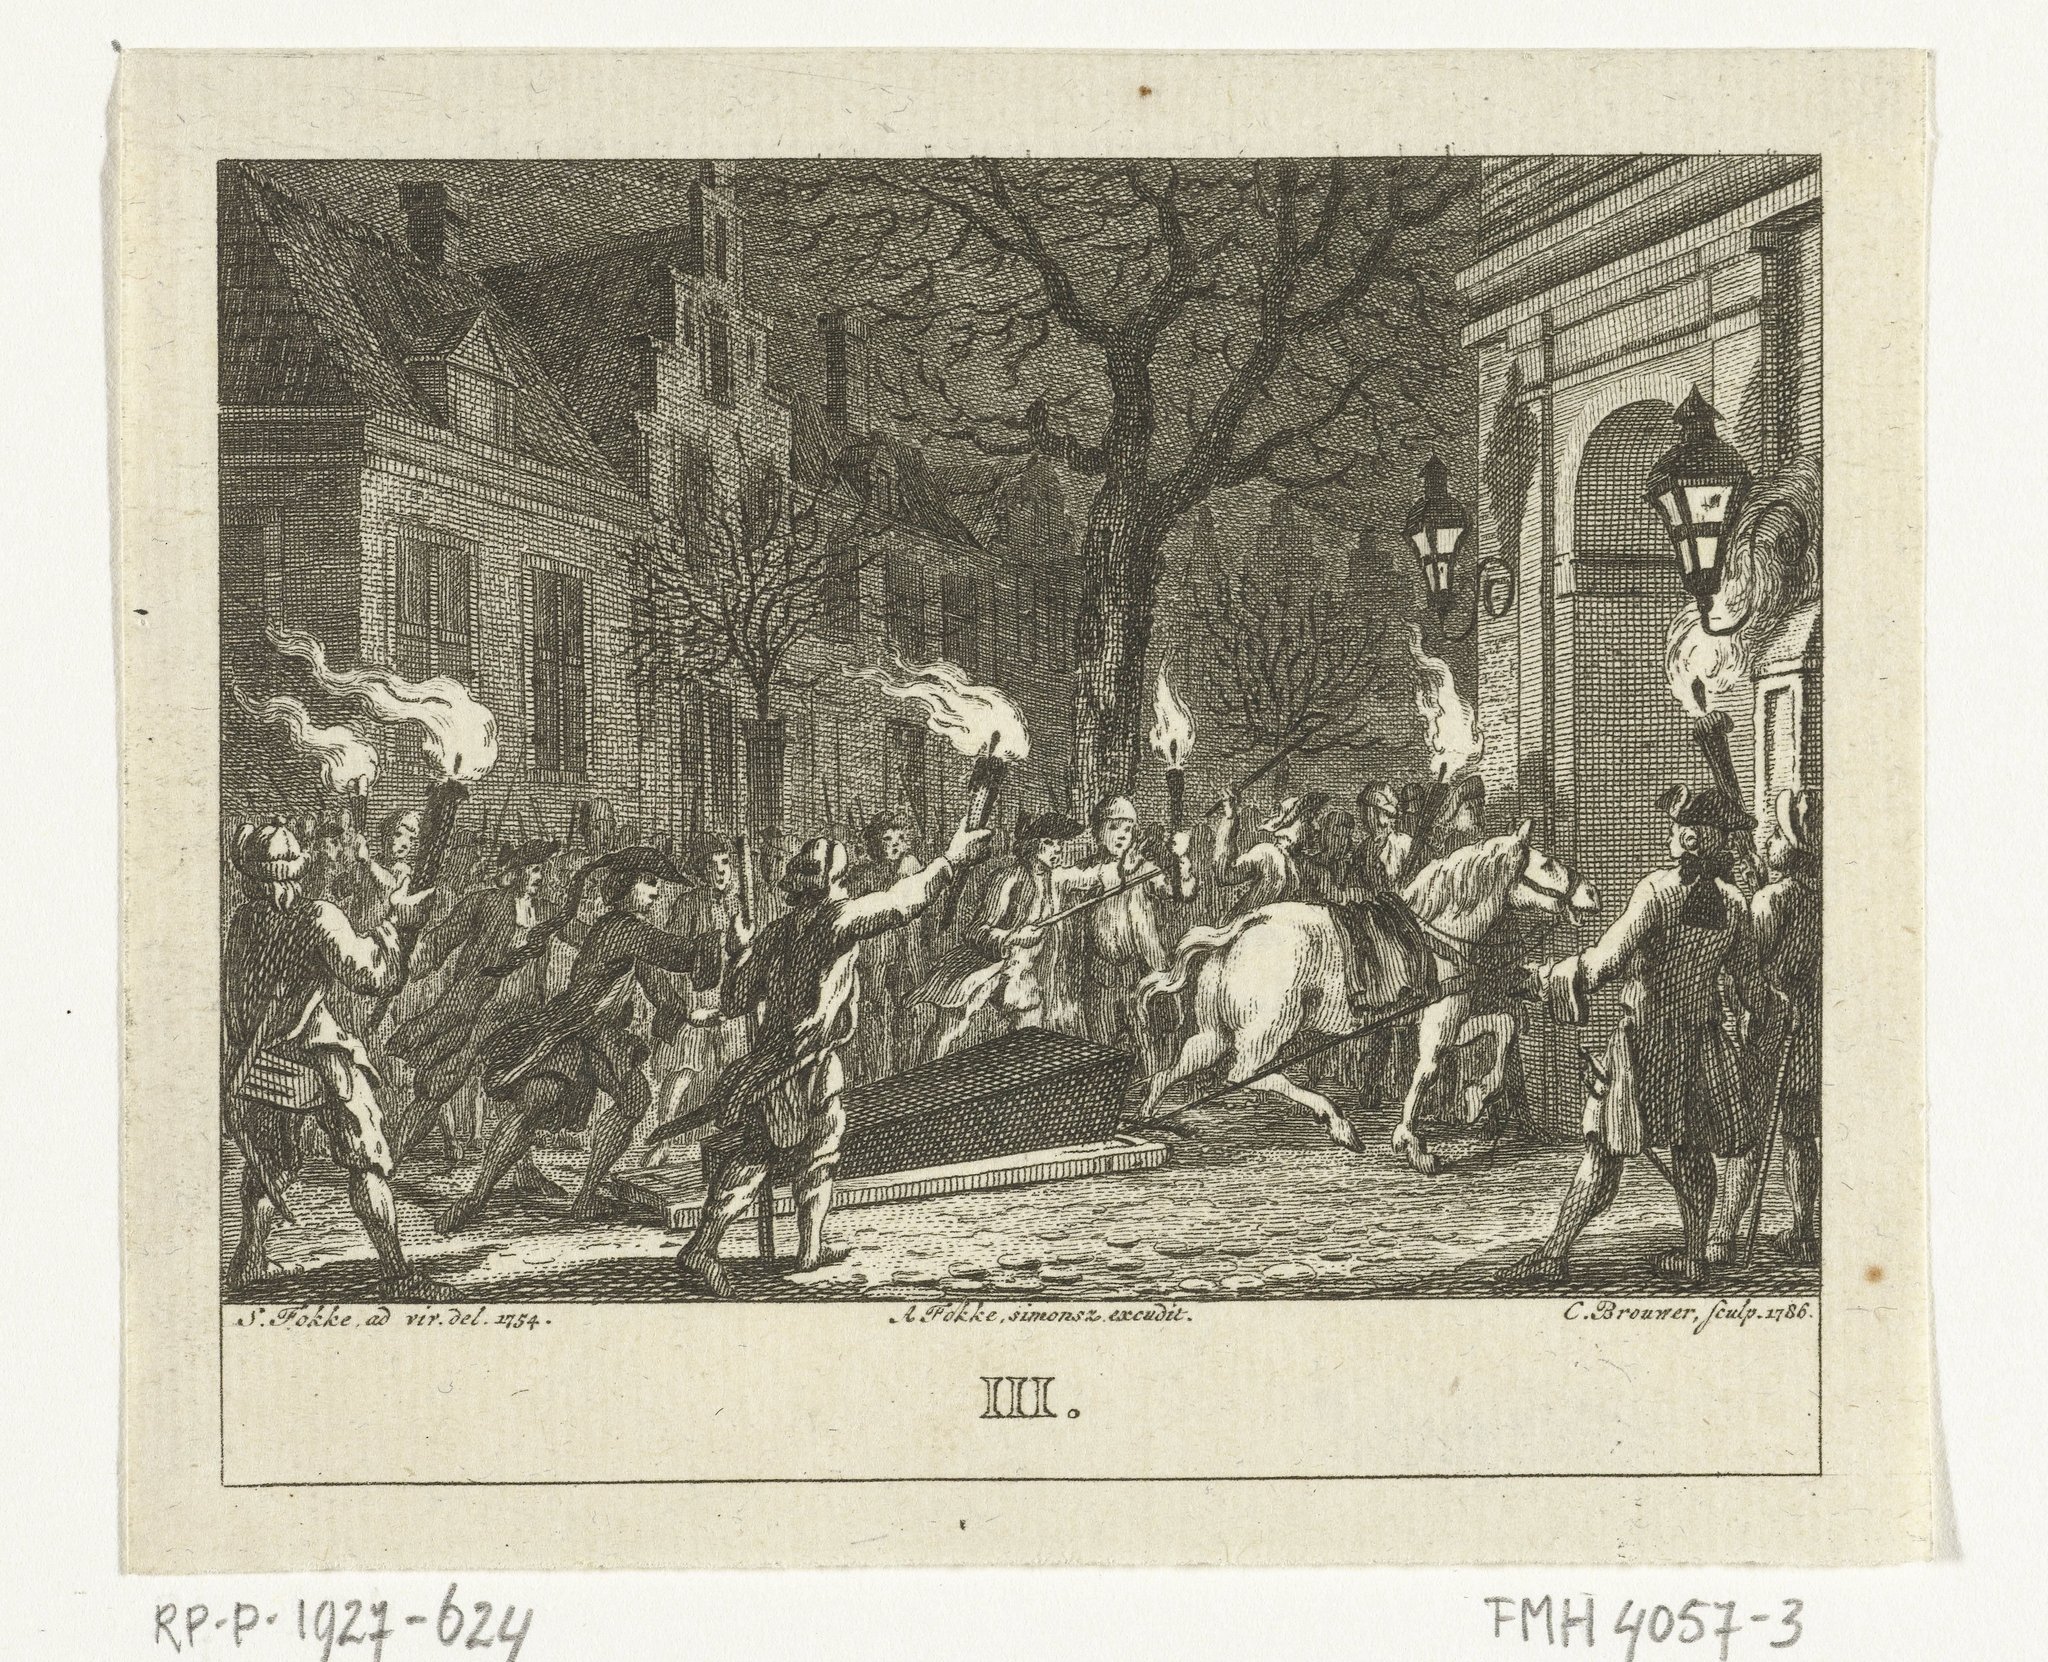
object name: print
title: Begrafenis van Daniël Raap te Amsterdam in 1754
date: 1786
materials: paper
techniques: etching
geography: netherlands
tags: funerary ceremonial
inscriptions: collector's mark: Lugt 2228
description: Gebruikt als illustratie in: Arend Fokke Simonsz. De vaderlandsche historie in themata. Amsterdam: Arend Fokke Simonsz., edities tussen 1783-ca. 1792. Daarbij zijn vier illustraties met de gebeurtenissen rond de begrafenis van Raap opgenomen, deze zijn genummerd 1 t/m 4.